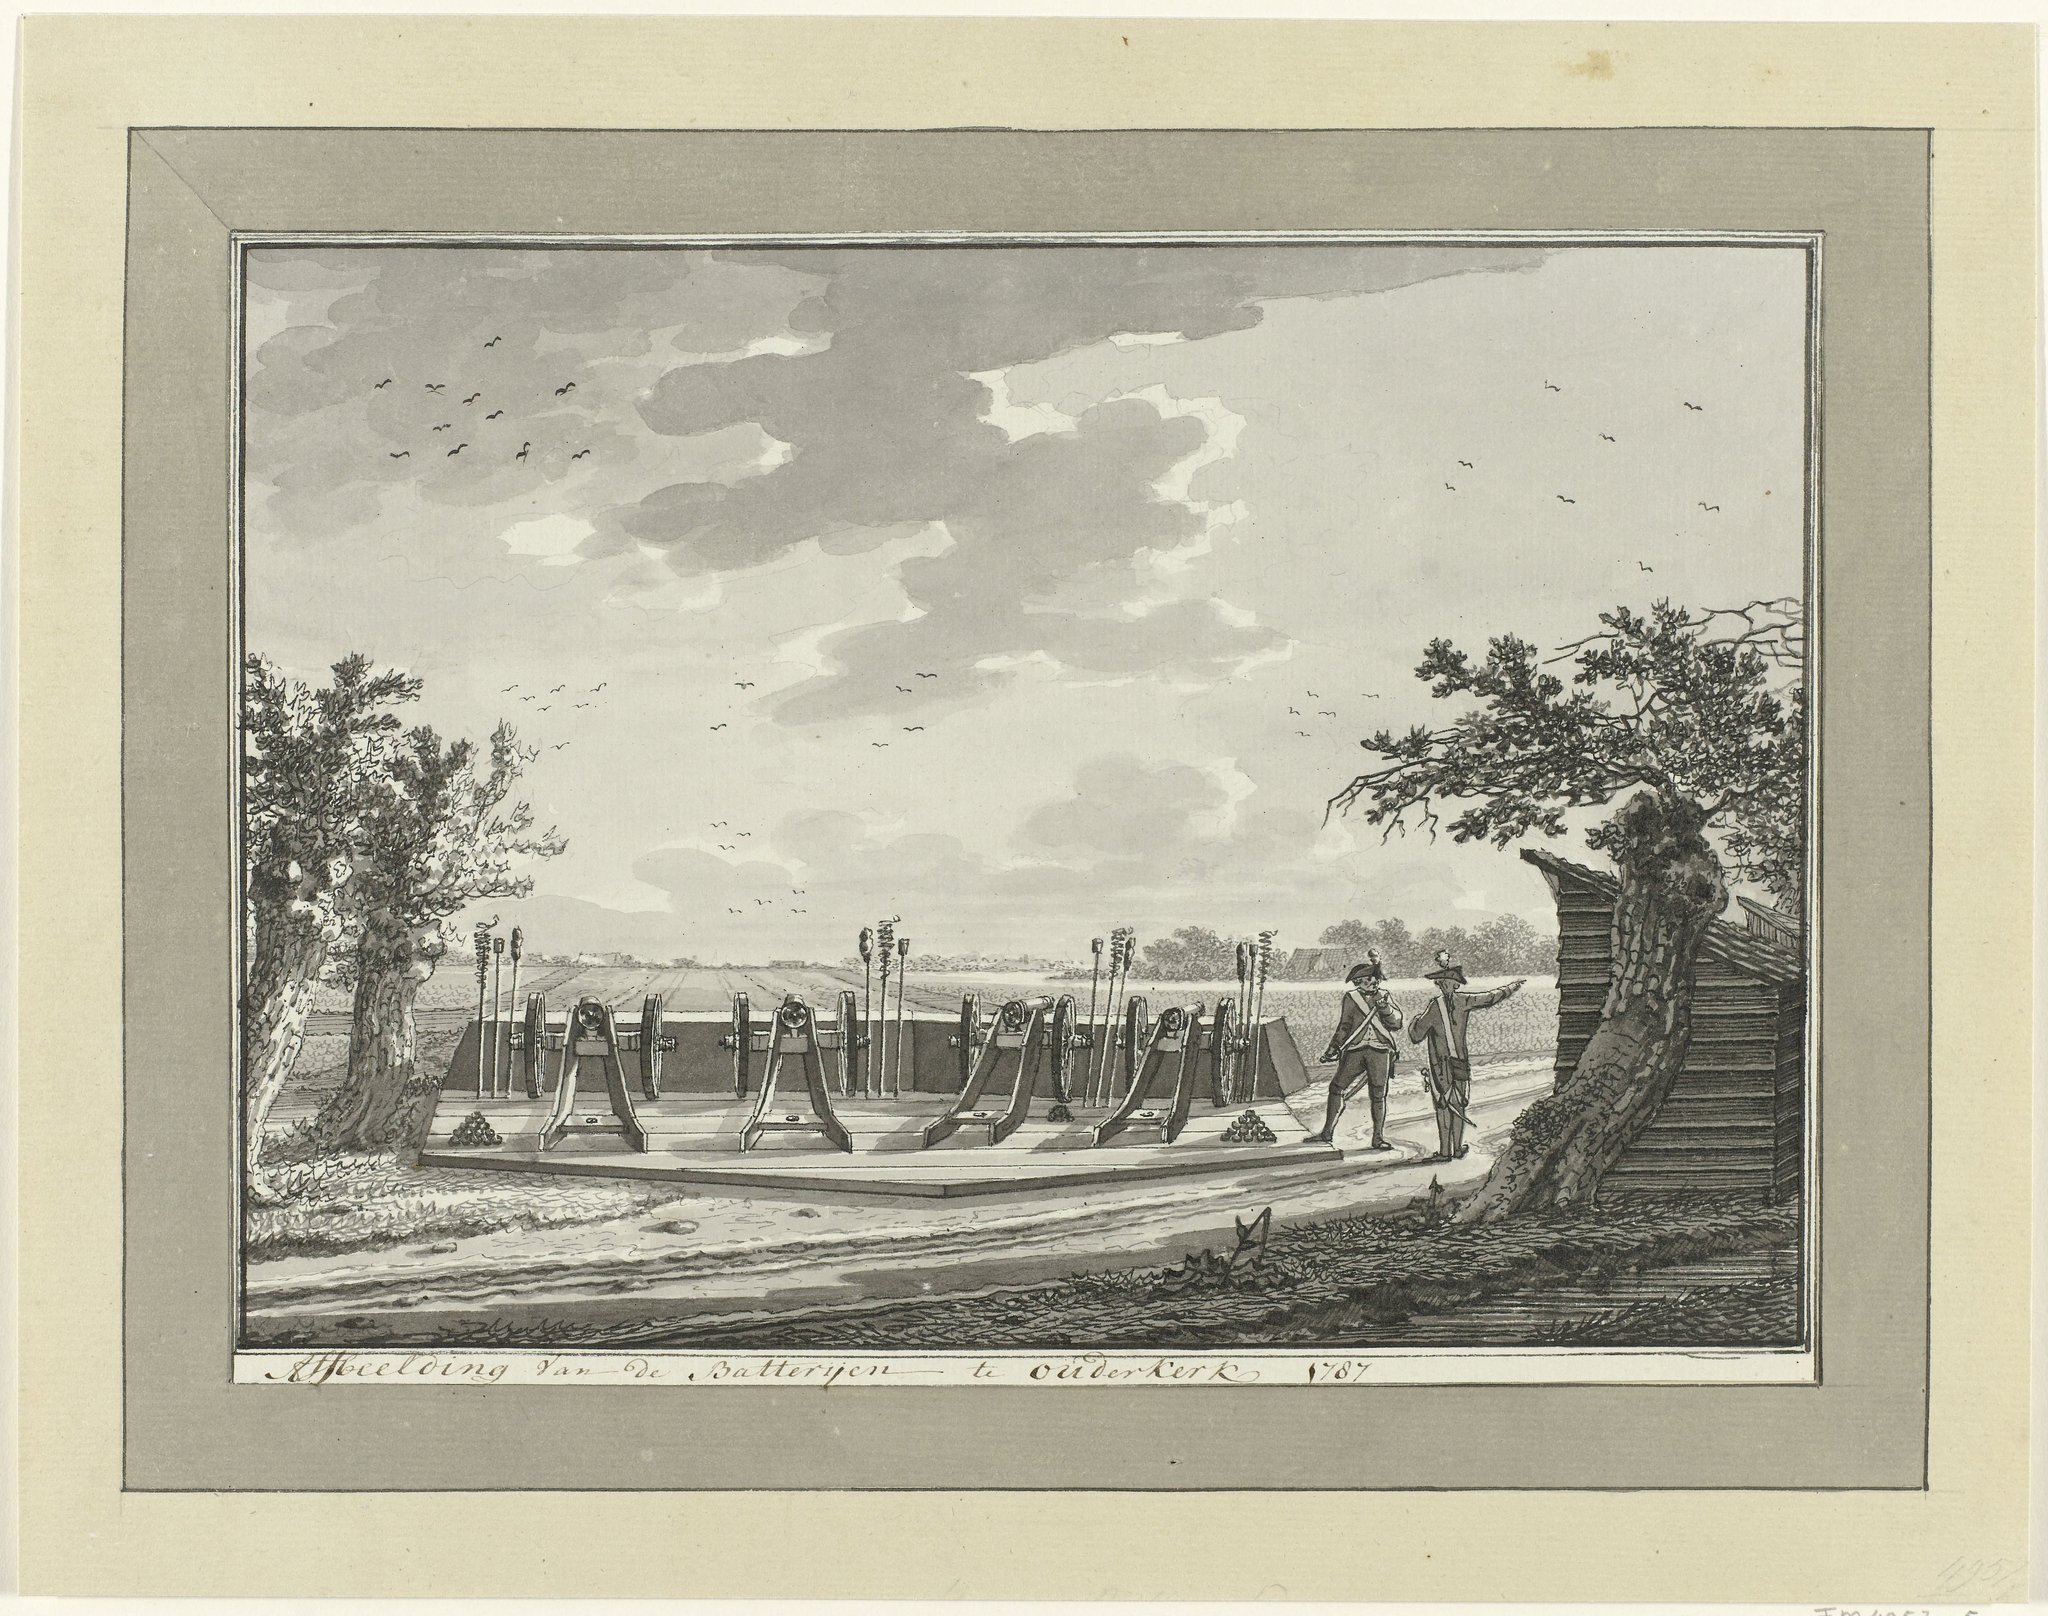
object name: drawing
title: Afbeelding van de Batterijen te Ouderkerk 1787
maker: Anonymous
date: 1787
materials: paper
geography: northern netherlands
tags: defence of fortification or city, defensive measures (military)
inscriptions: collector's mark: Lugt 2228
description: Battterij aan de Binnen Bullewijk. Onderdeel van een groep van tien tekeningen van de verdedigingen aangelegd door de patriotten rondom Amsterdam ten tijde van de inval van de Pruisische troepen in september 1787.